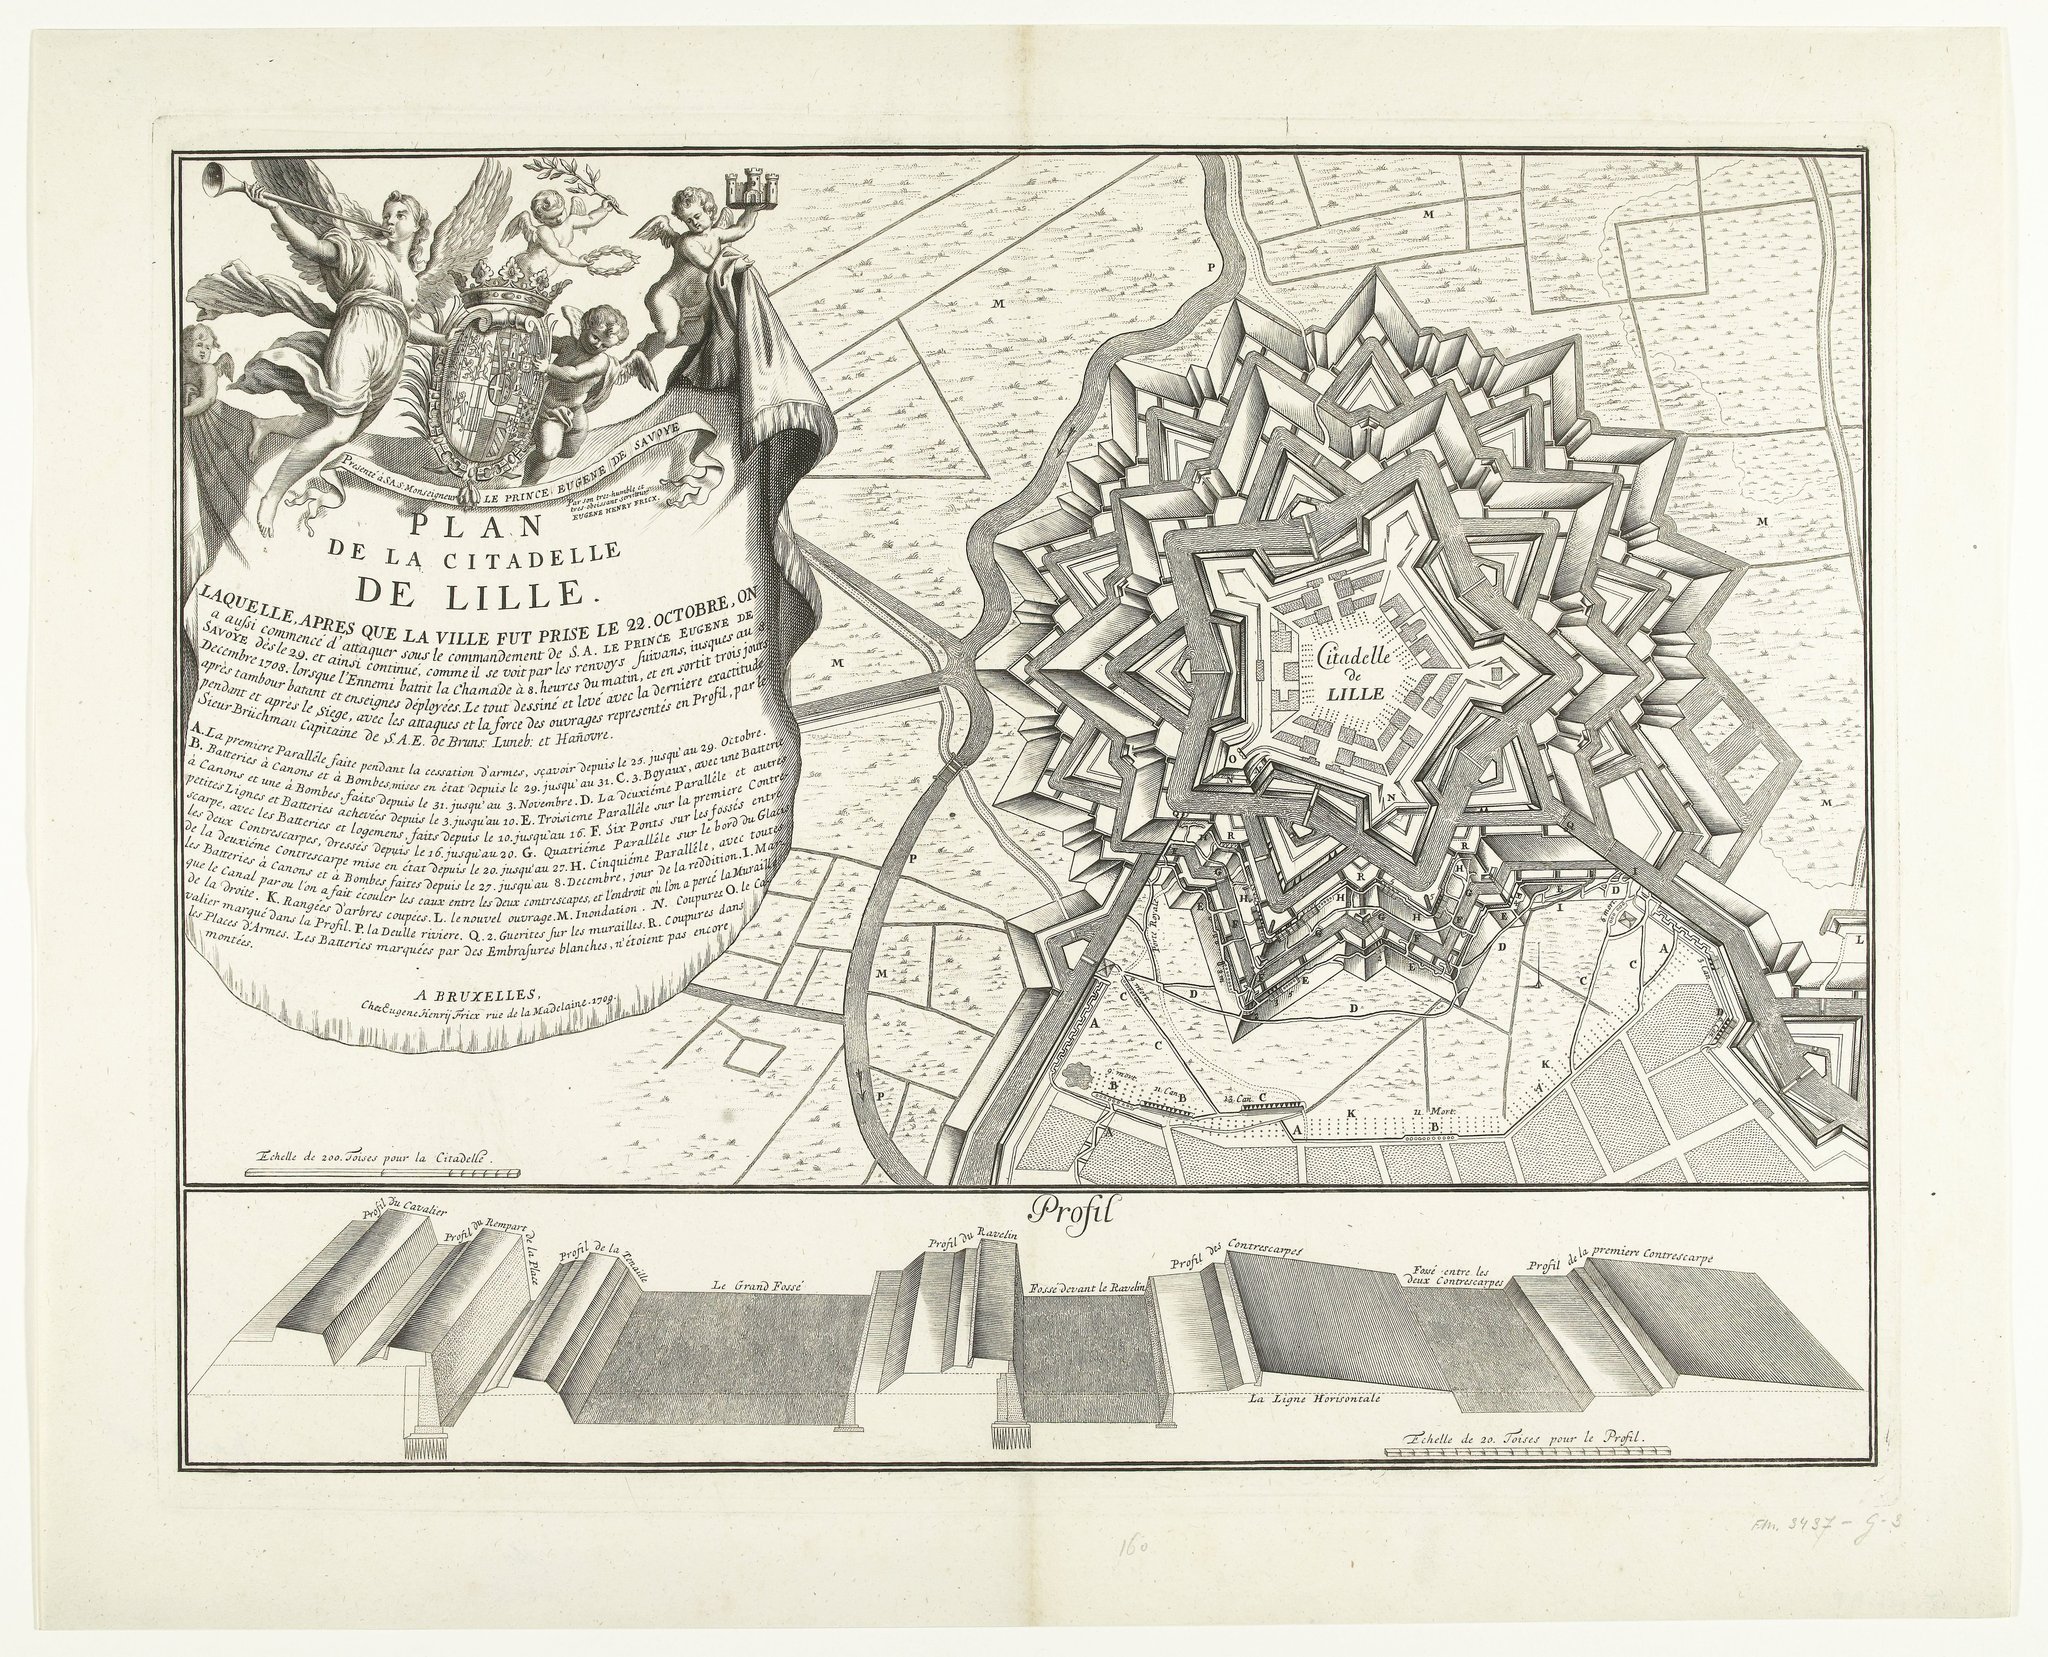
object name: print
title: Plan de la citadelle de Lille. Laquelle, apres que la ville fut prise le 22. octobre, on a aussi commencé d'attaquer (...)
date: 1709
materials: paper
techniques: engraving, etching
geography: brussels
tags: paris, vienna, eugenius van savoye, fortress, maps of cities, lille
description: Plattegrond van de citadel van Lille (Rijssel), belegerd vanaf 22 oktober door de Geallieerden onder prins Eugenius van Savoye en veroverd op 8 december. Onderaan een doorsnede van de wallen en grachten om het kasteel. Links een grote cartouche met de titel en legenda A-R in het Frans, met de Faam en engelen met het wapen van de prins van Savoye.